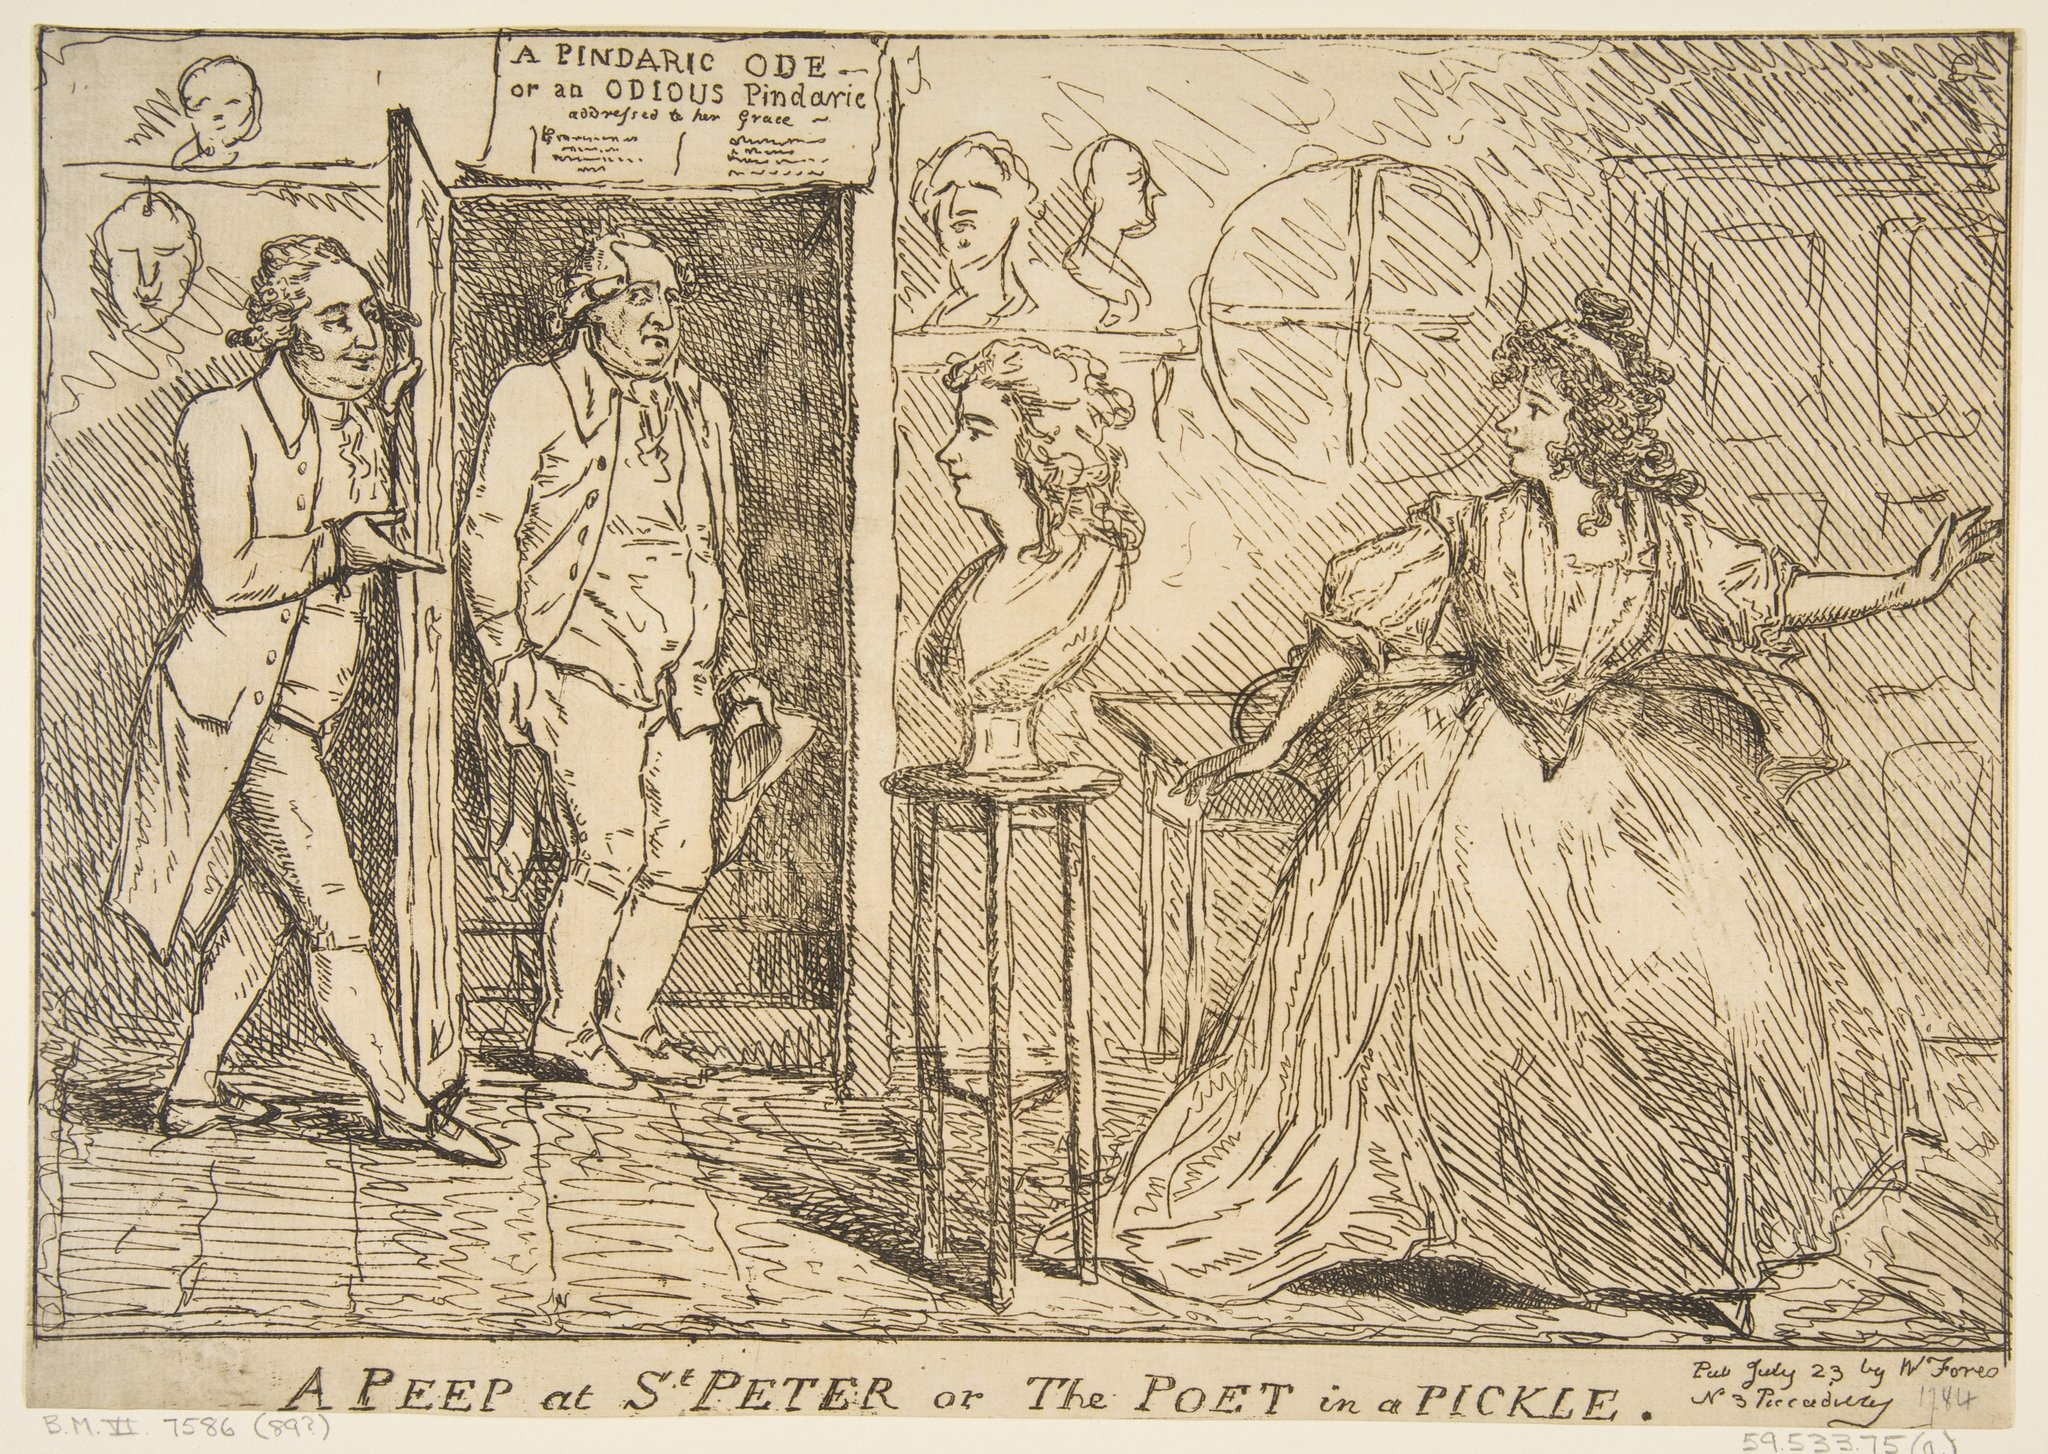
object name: print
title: A Peep at St. Peter or The Poet in a Pickle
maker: anonymous, british, 18th century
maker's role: artist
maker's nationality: british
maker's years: 1700-1800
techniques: etching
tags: satire,men,women